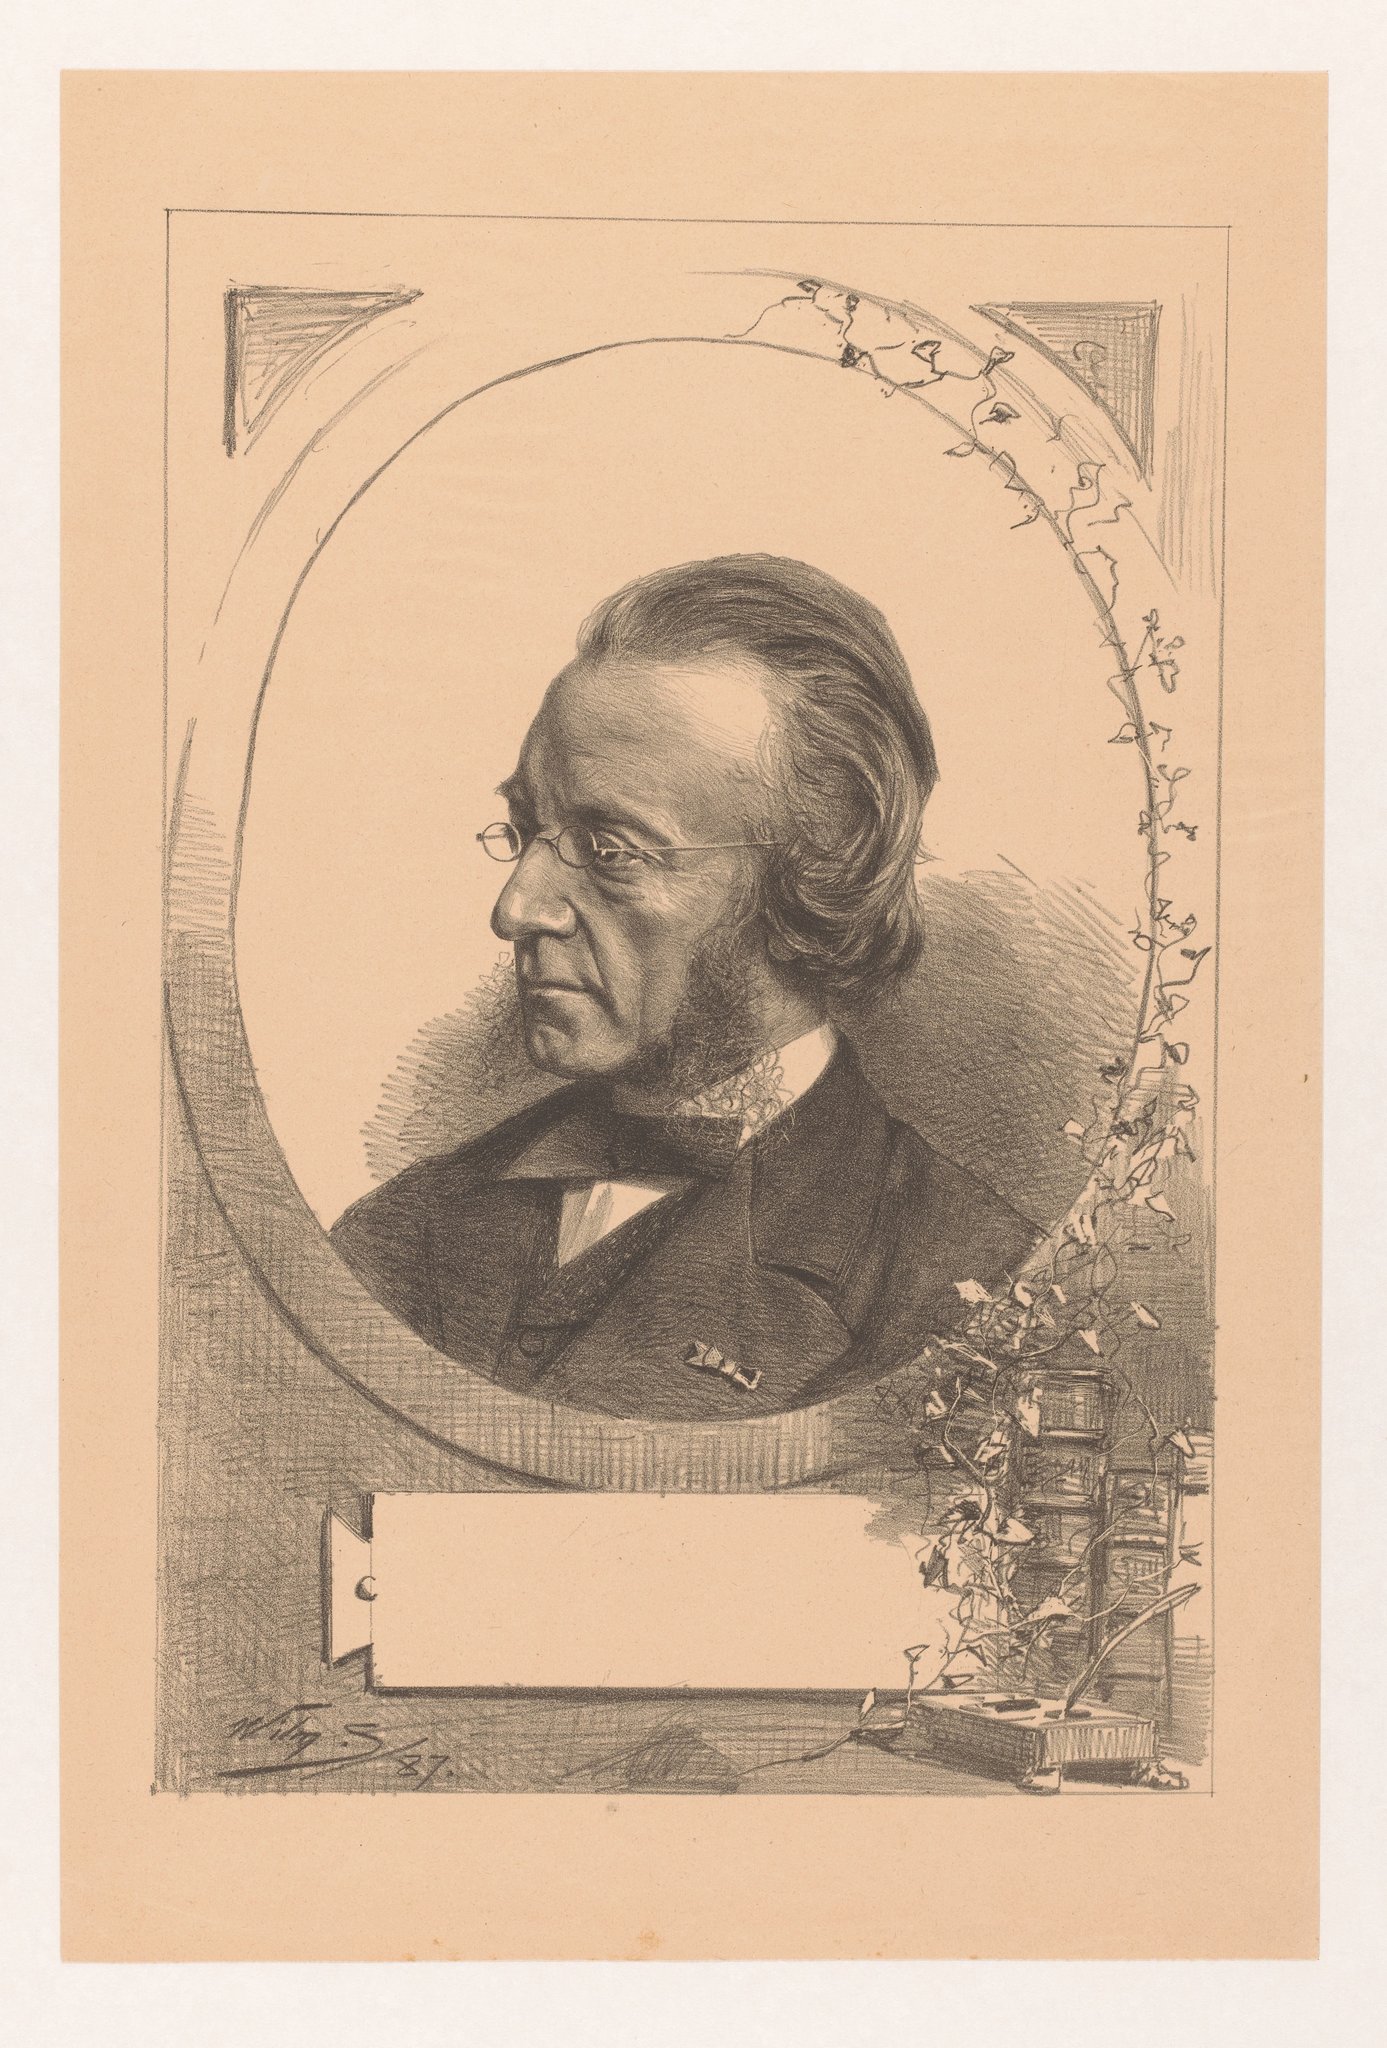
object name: print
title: Portret van Josephus Albertus Alberdingk Thijm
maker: willem steelink (ii)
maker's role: draughtsman, print maker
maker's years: 1856-1928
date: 1887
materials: paper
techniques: lithograph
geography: amsterdam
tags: amsterdam, painter, draughtsman, publisher, josephus albertus alberdingk thijm, historical persons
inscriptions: collector's mark: Lugt 2228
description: Proefdruk voor prent uit: De Amsterdammer, 1887-08-18.